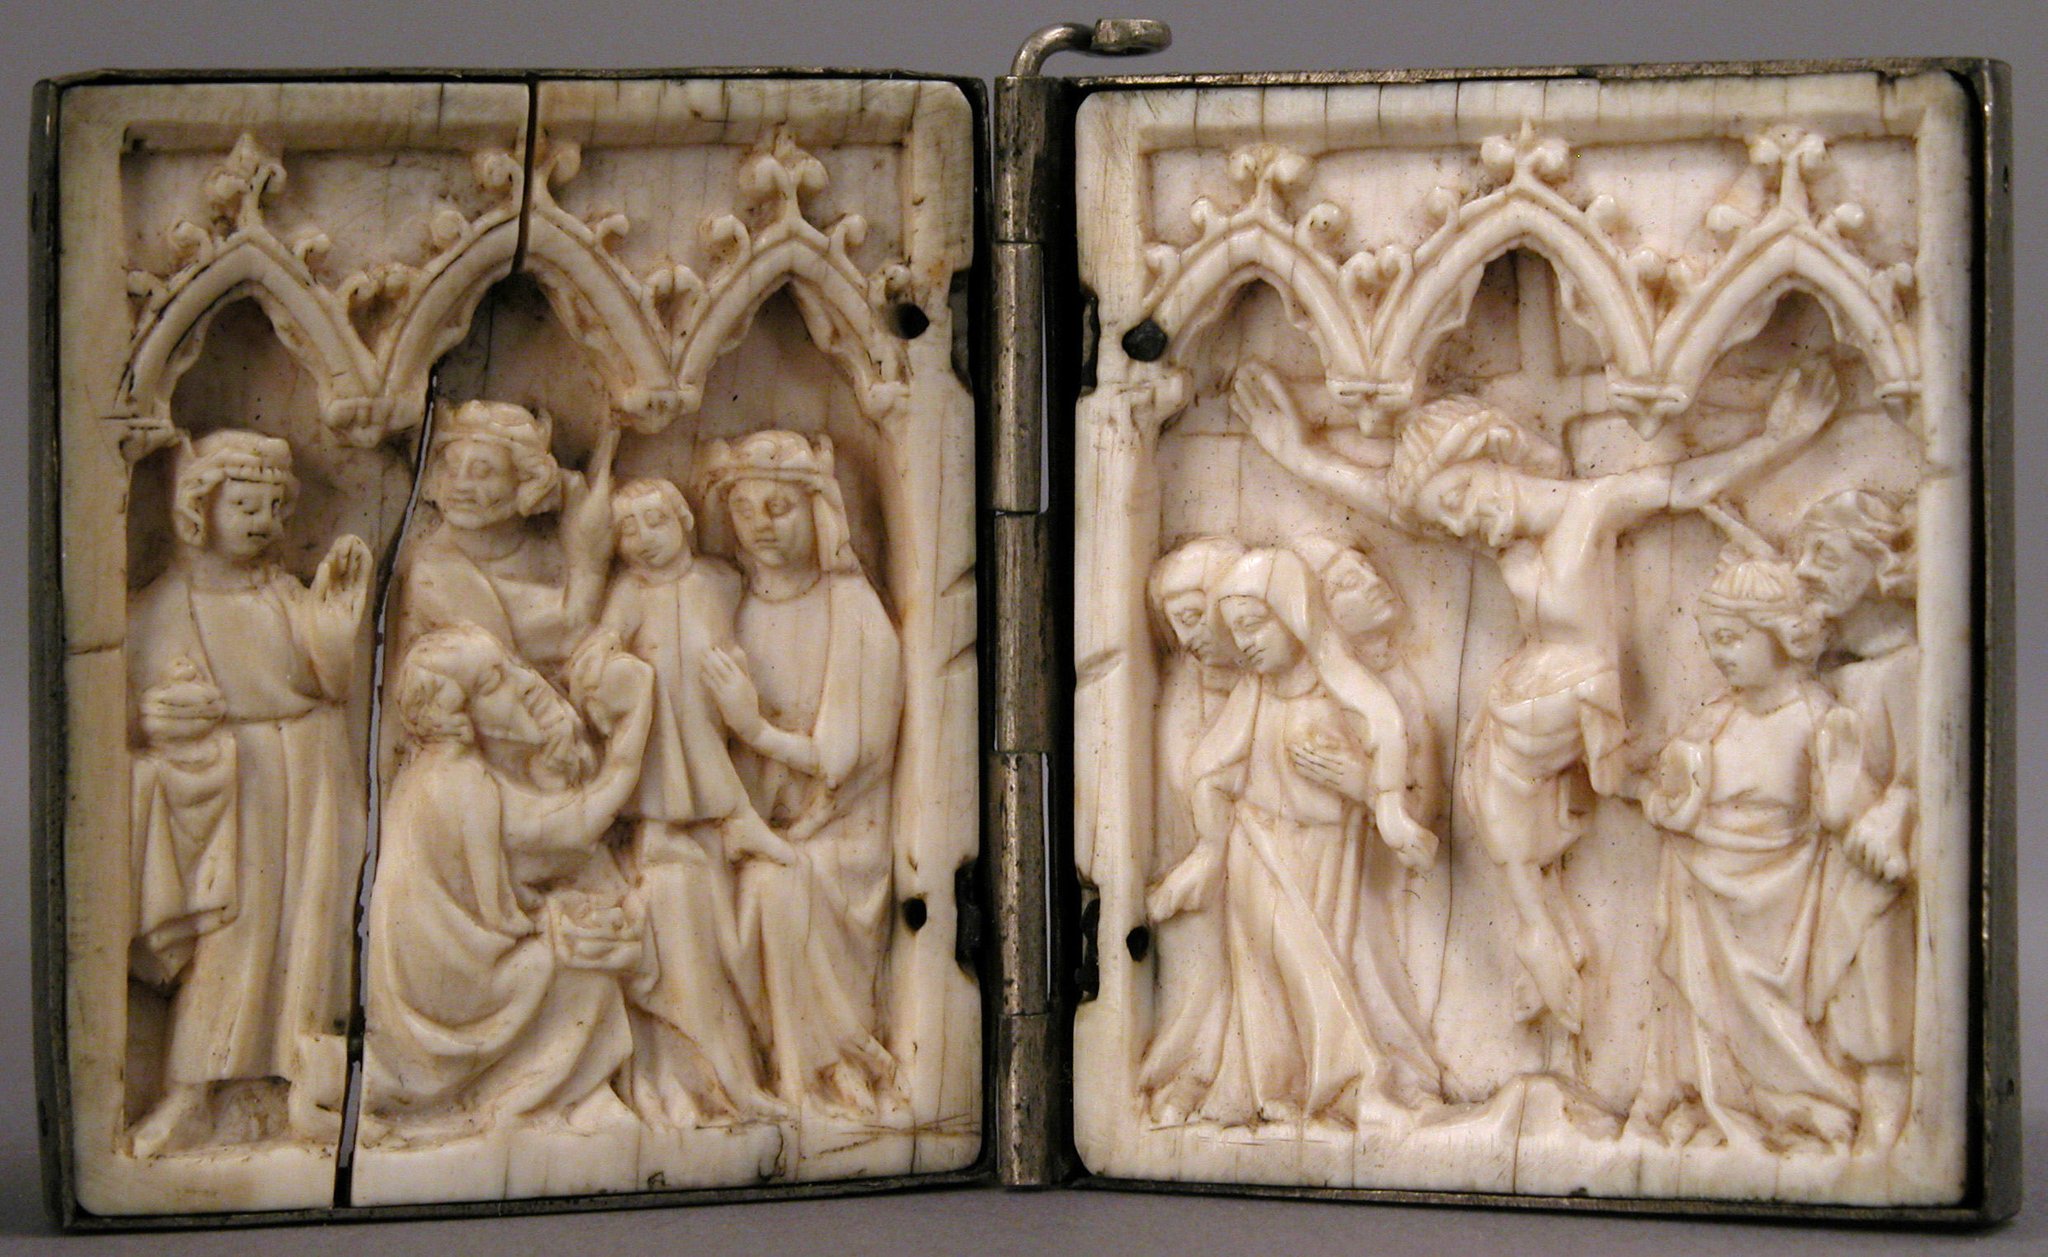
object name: diptych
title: Diptych with Adoration of the Magi and Crucifixion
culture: french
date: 1301-1400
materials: ivory, silver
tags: christ,adoration of the magi,crucifixion